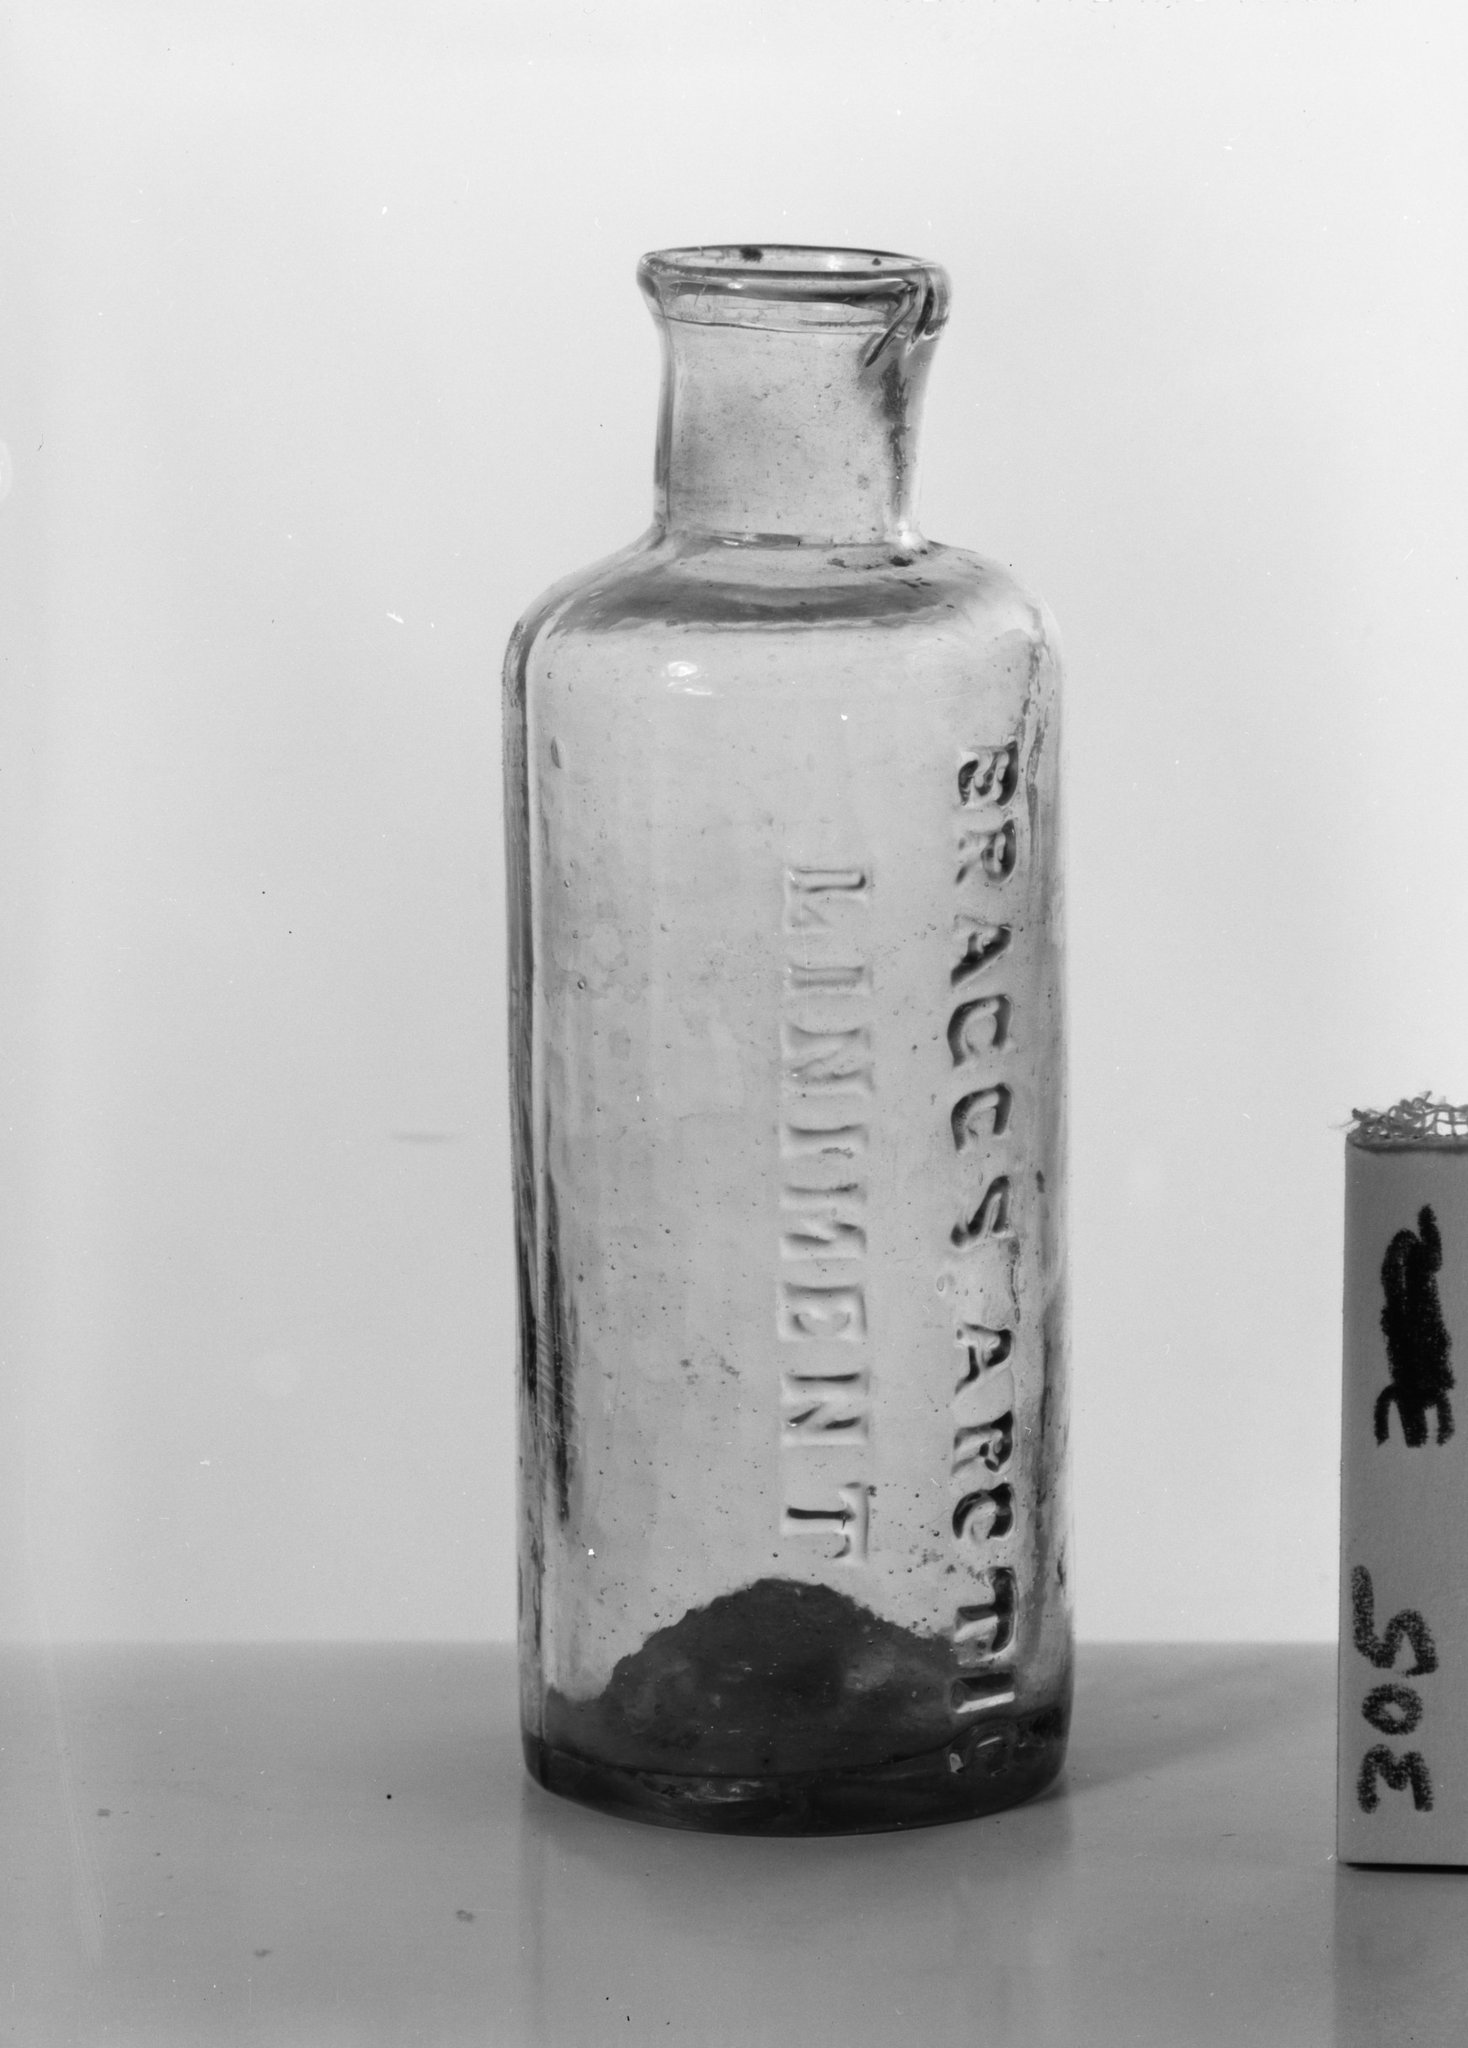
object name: bottle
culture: american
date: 1700-1800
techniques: glassblowing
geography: united states